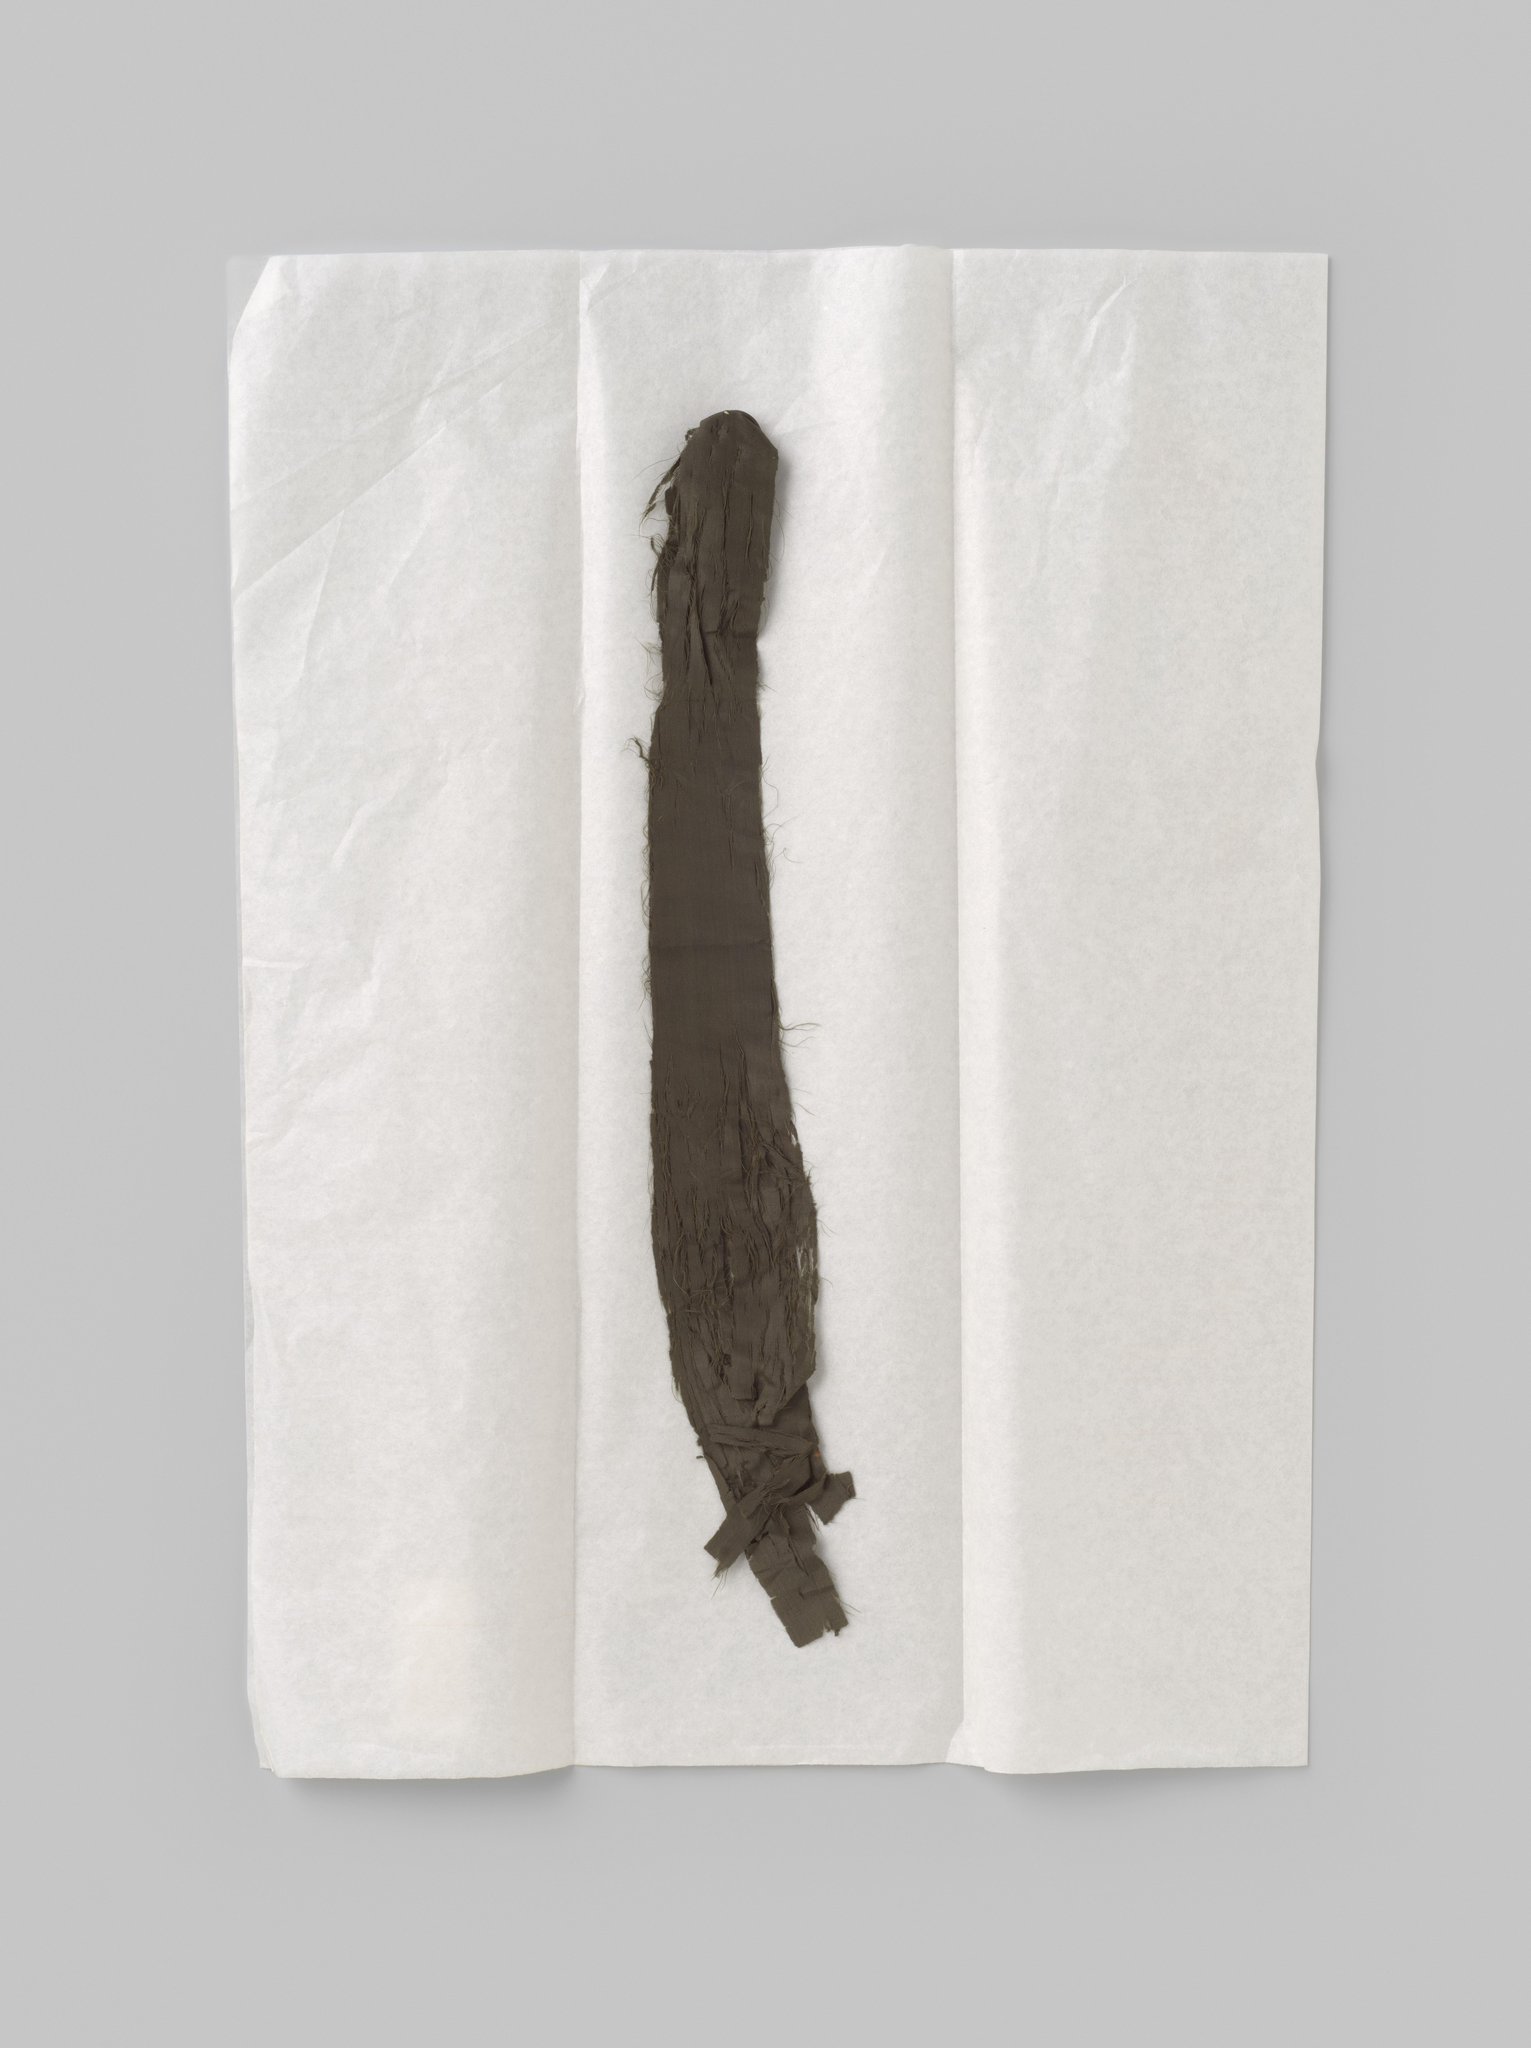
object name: parasol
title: Hoes van parasol met flesgroene zijde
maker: Anonymous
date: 1905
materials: silk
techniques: weave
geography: brussels